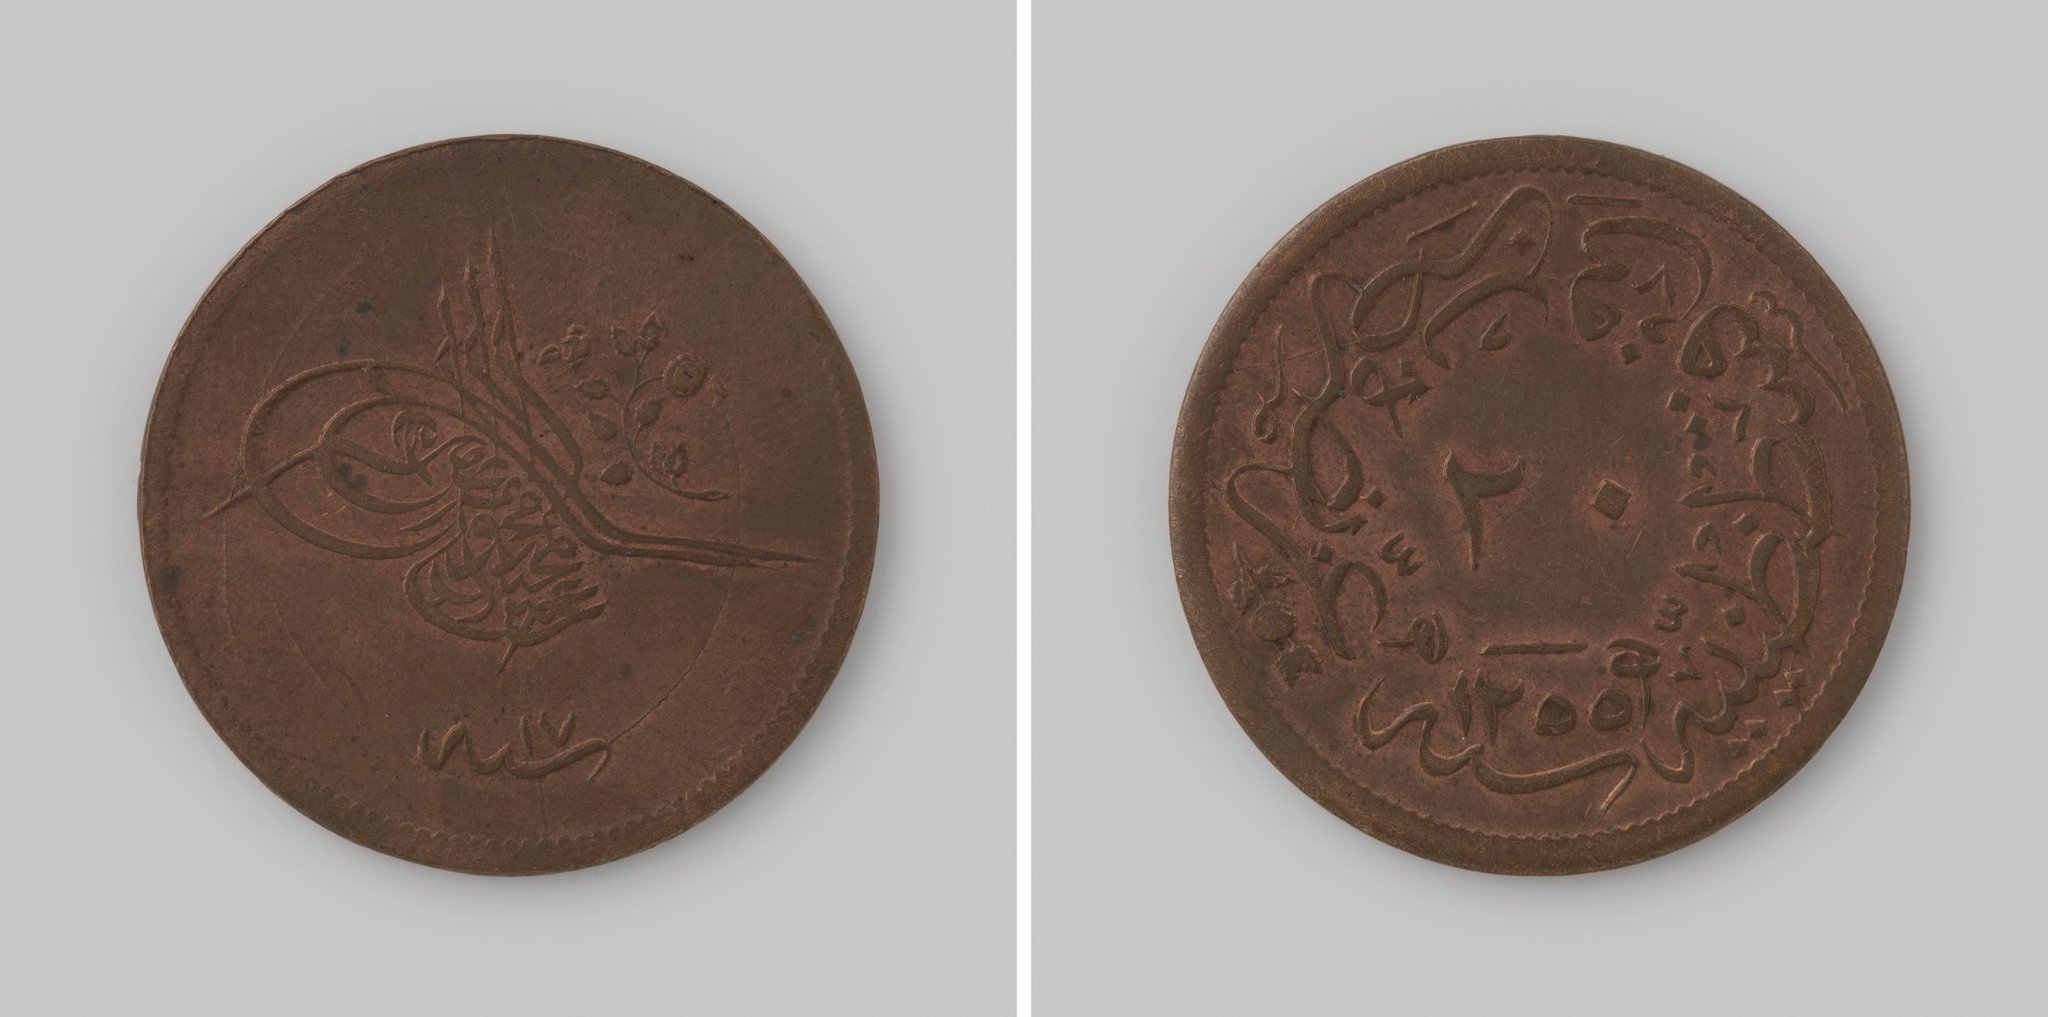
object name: coin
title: 20 para uit Turkije van sultan Abdul Medjid, regeringsjaar 17 [=1855]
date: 1855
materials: copper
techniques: striking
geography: constantinople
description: Koperen munt. Voorzijde: tughra met rechts daarvan takje met bladeren. Onder tughra regeringsjaar-aanduiding: 17. Keerzijde: binnen omschrift in Arabische letters waarde-aanduiding: 20. In omschrift muntplaats-aanduiding: Constantinopel en aanduiding jaar van aantreden: 1255 [=1839].